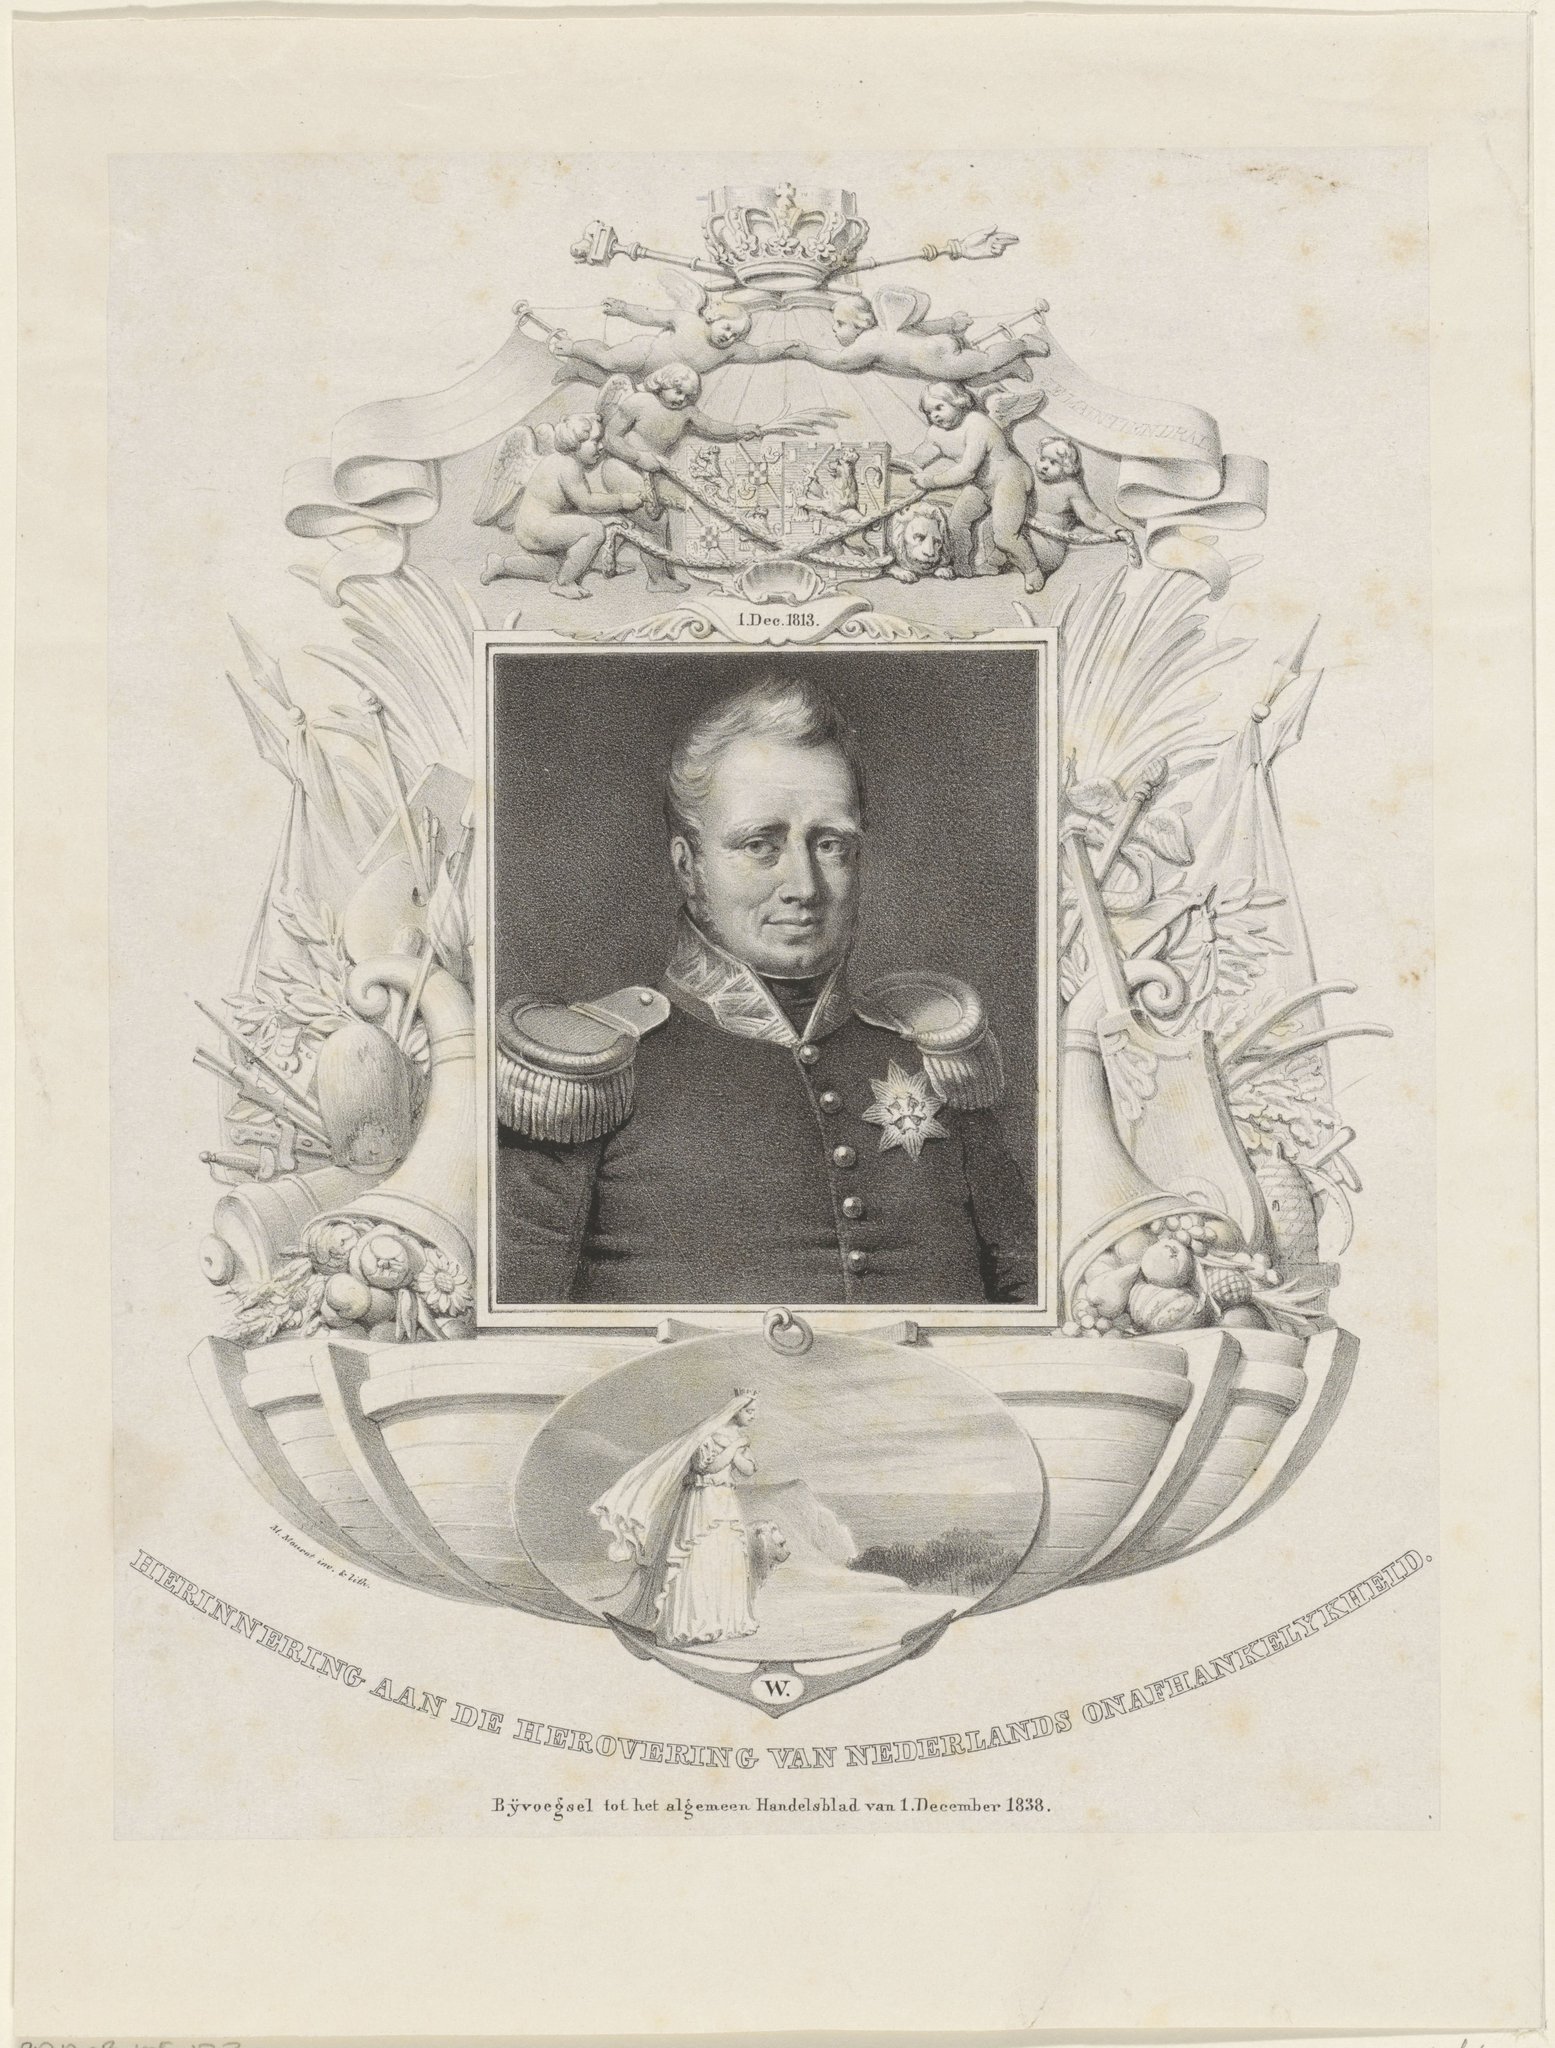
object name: print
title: Portret van Willem I Frederik, koning der Nederlanden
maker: michel mourot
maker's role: draughtsman, print maker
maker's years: 1803-1847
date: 1838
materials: paper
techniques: lithograph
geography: netherlands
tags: the hague, berlin, william i of the netherlands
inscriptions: date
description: Portret van Willem I Frederik in een geornamenteerde rechthoek. Daar omheen een aantal allegorische objecten. Midden boven twee wapens met een kroon, een leeuw, zijn geslachtsspreuk en een aantal putti. Midden onder een allegorische voorstelling met de Nederlandse Maagd. In de ondermarge twee regels Nederlandse tekst. Bijvoegsel van het 'Algemeen Handelsblad'.